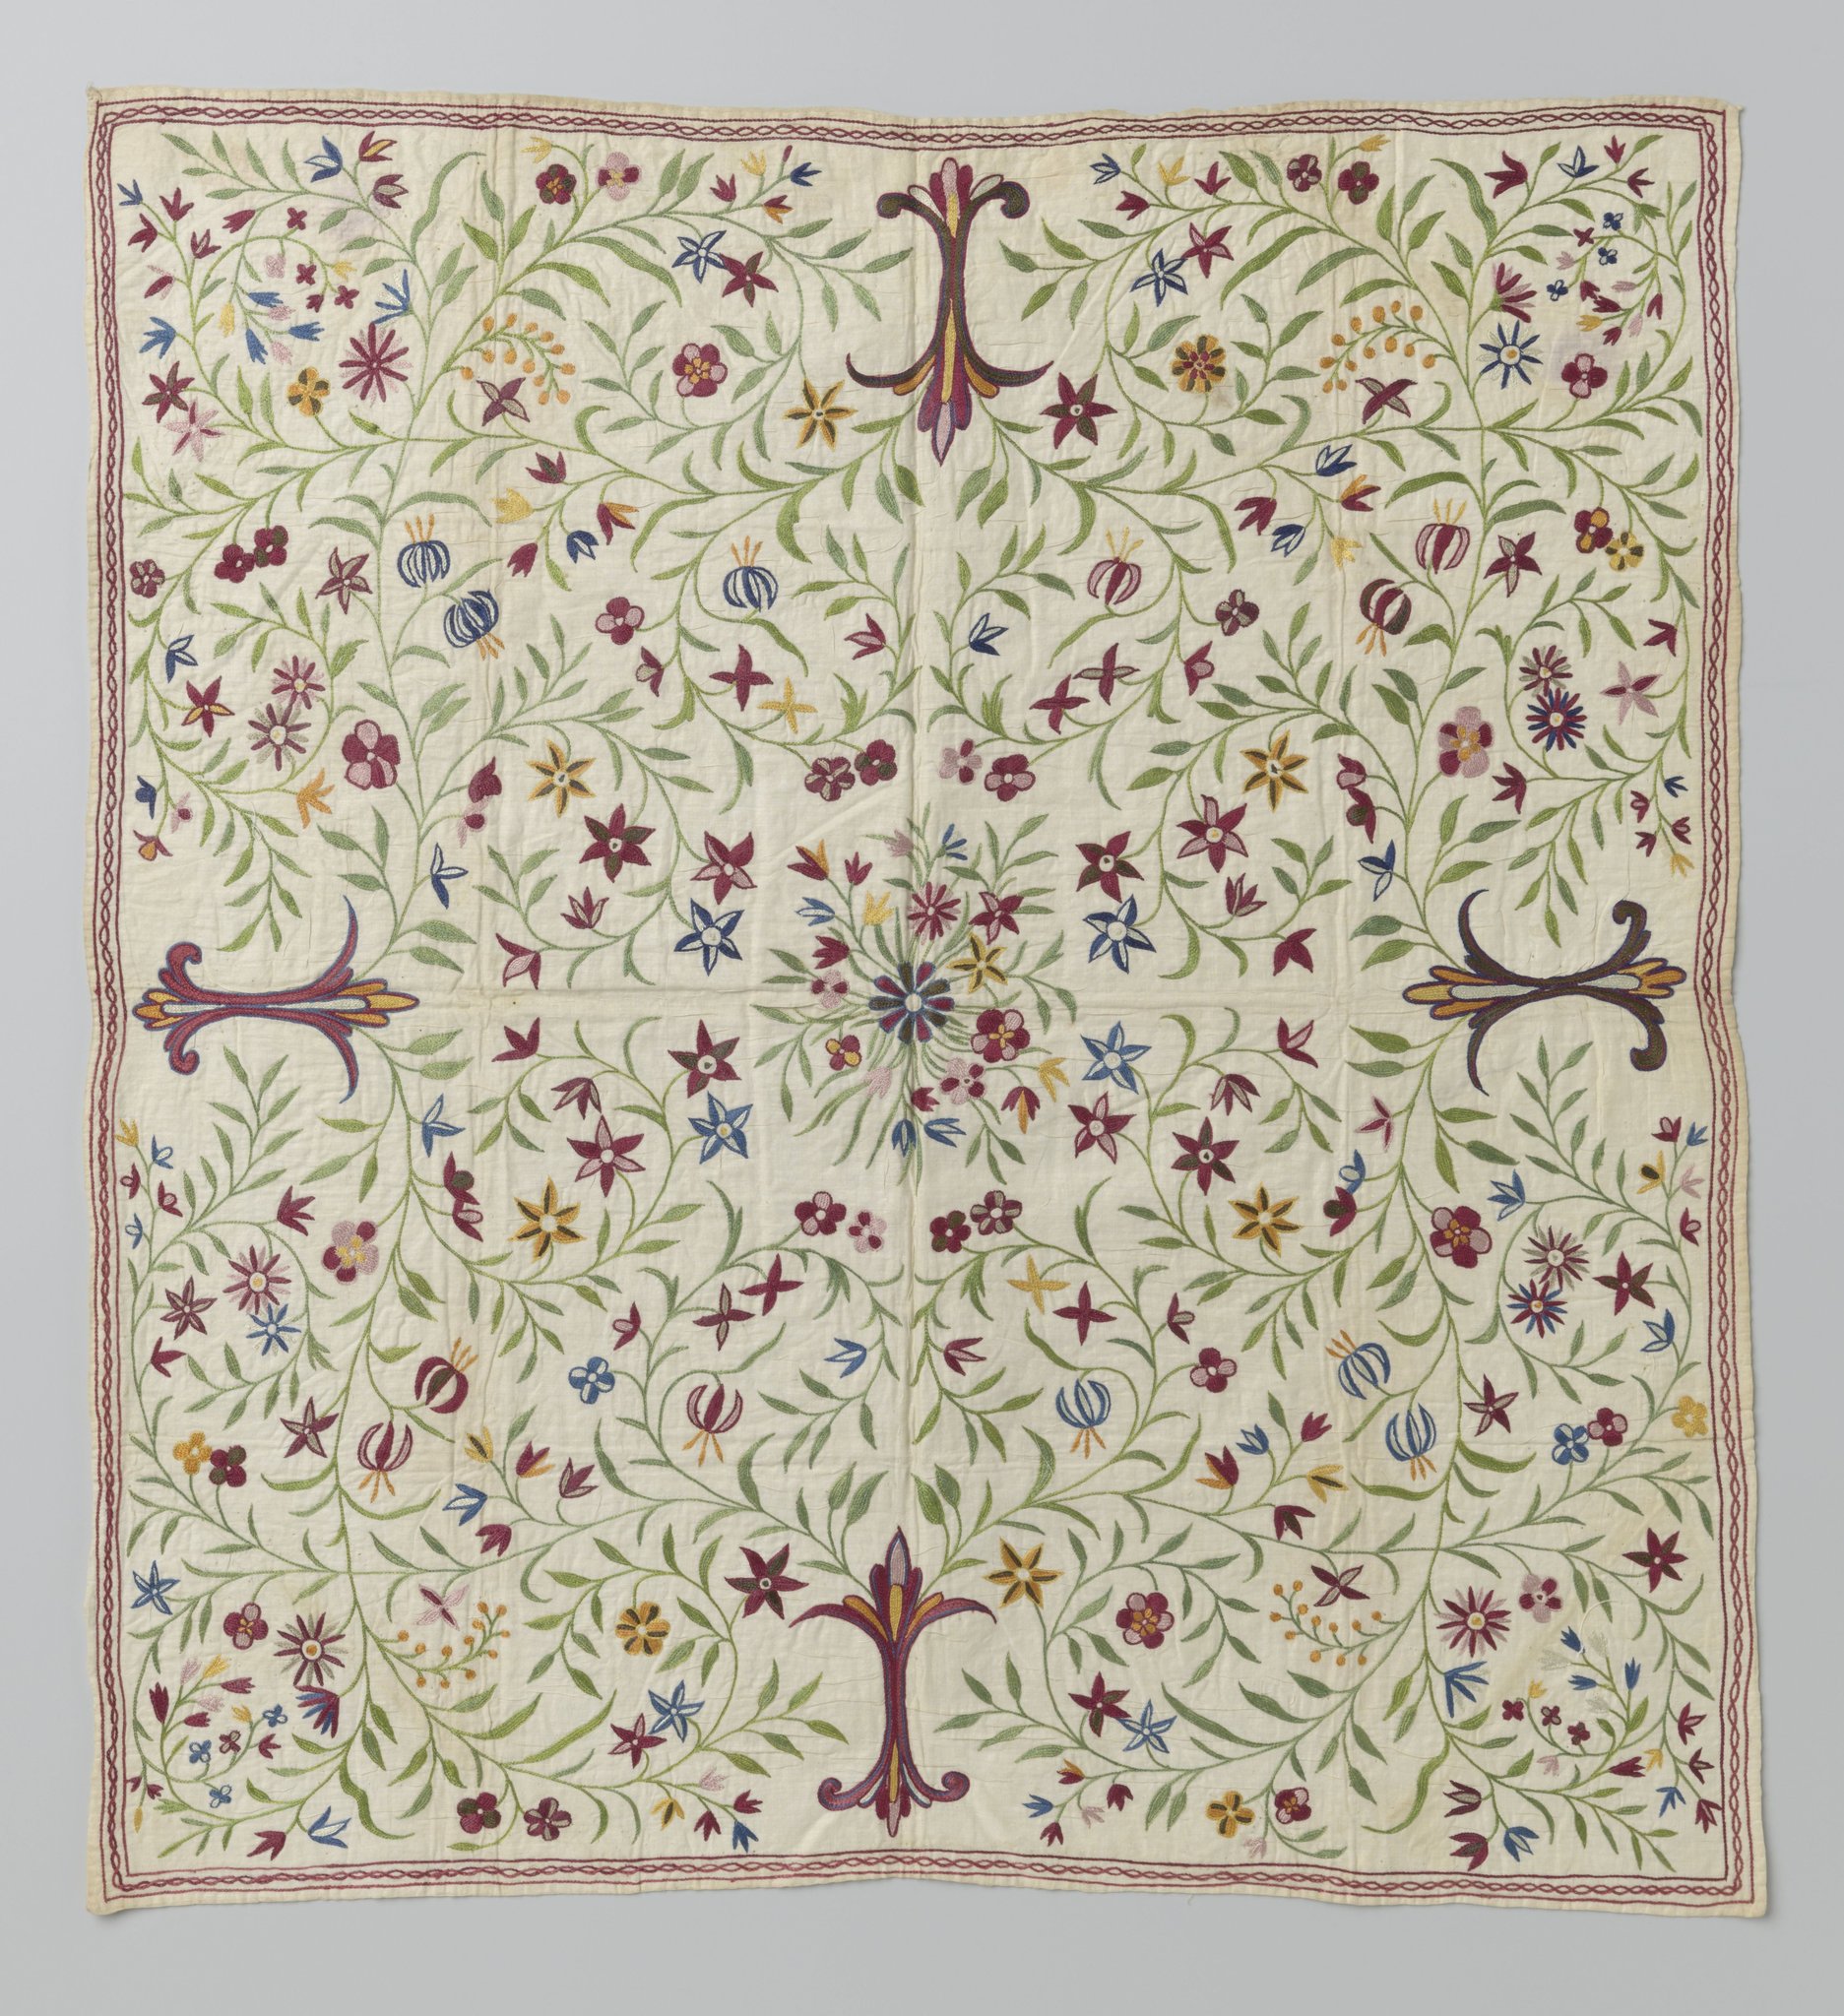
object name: kleed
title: Kleed van oosterse textiel met veelkleurig borduurwerk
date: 1800-1899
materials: cotton, silk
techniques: embroidered, weave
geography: east indies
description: Kleed van veelkleurig getamboereerde katoen, versierd met bloemranken en ornament, gevoerd met katoen.